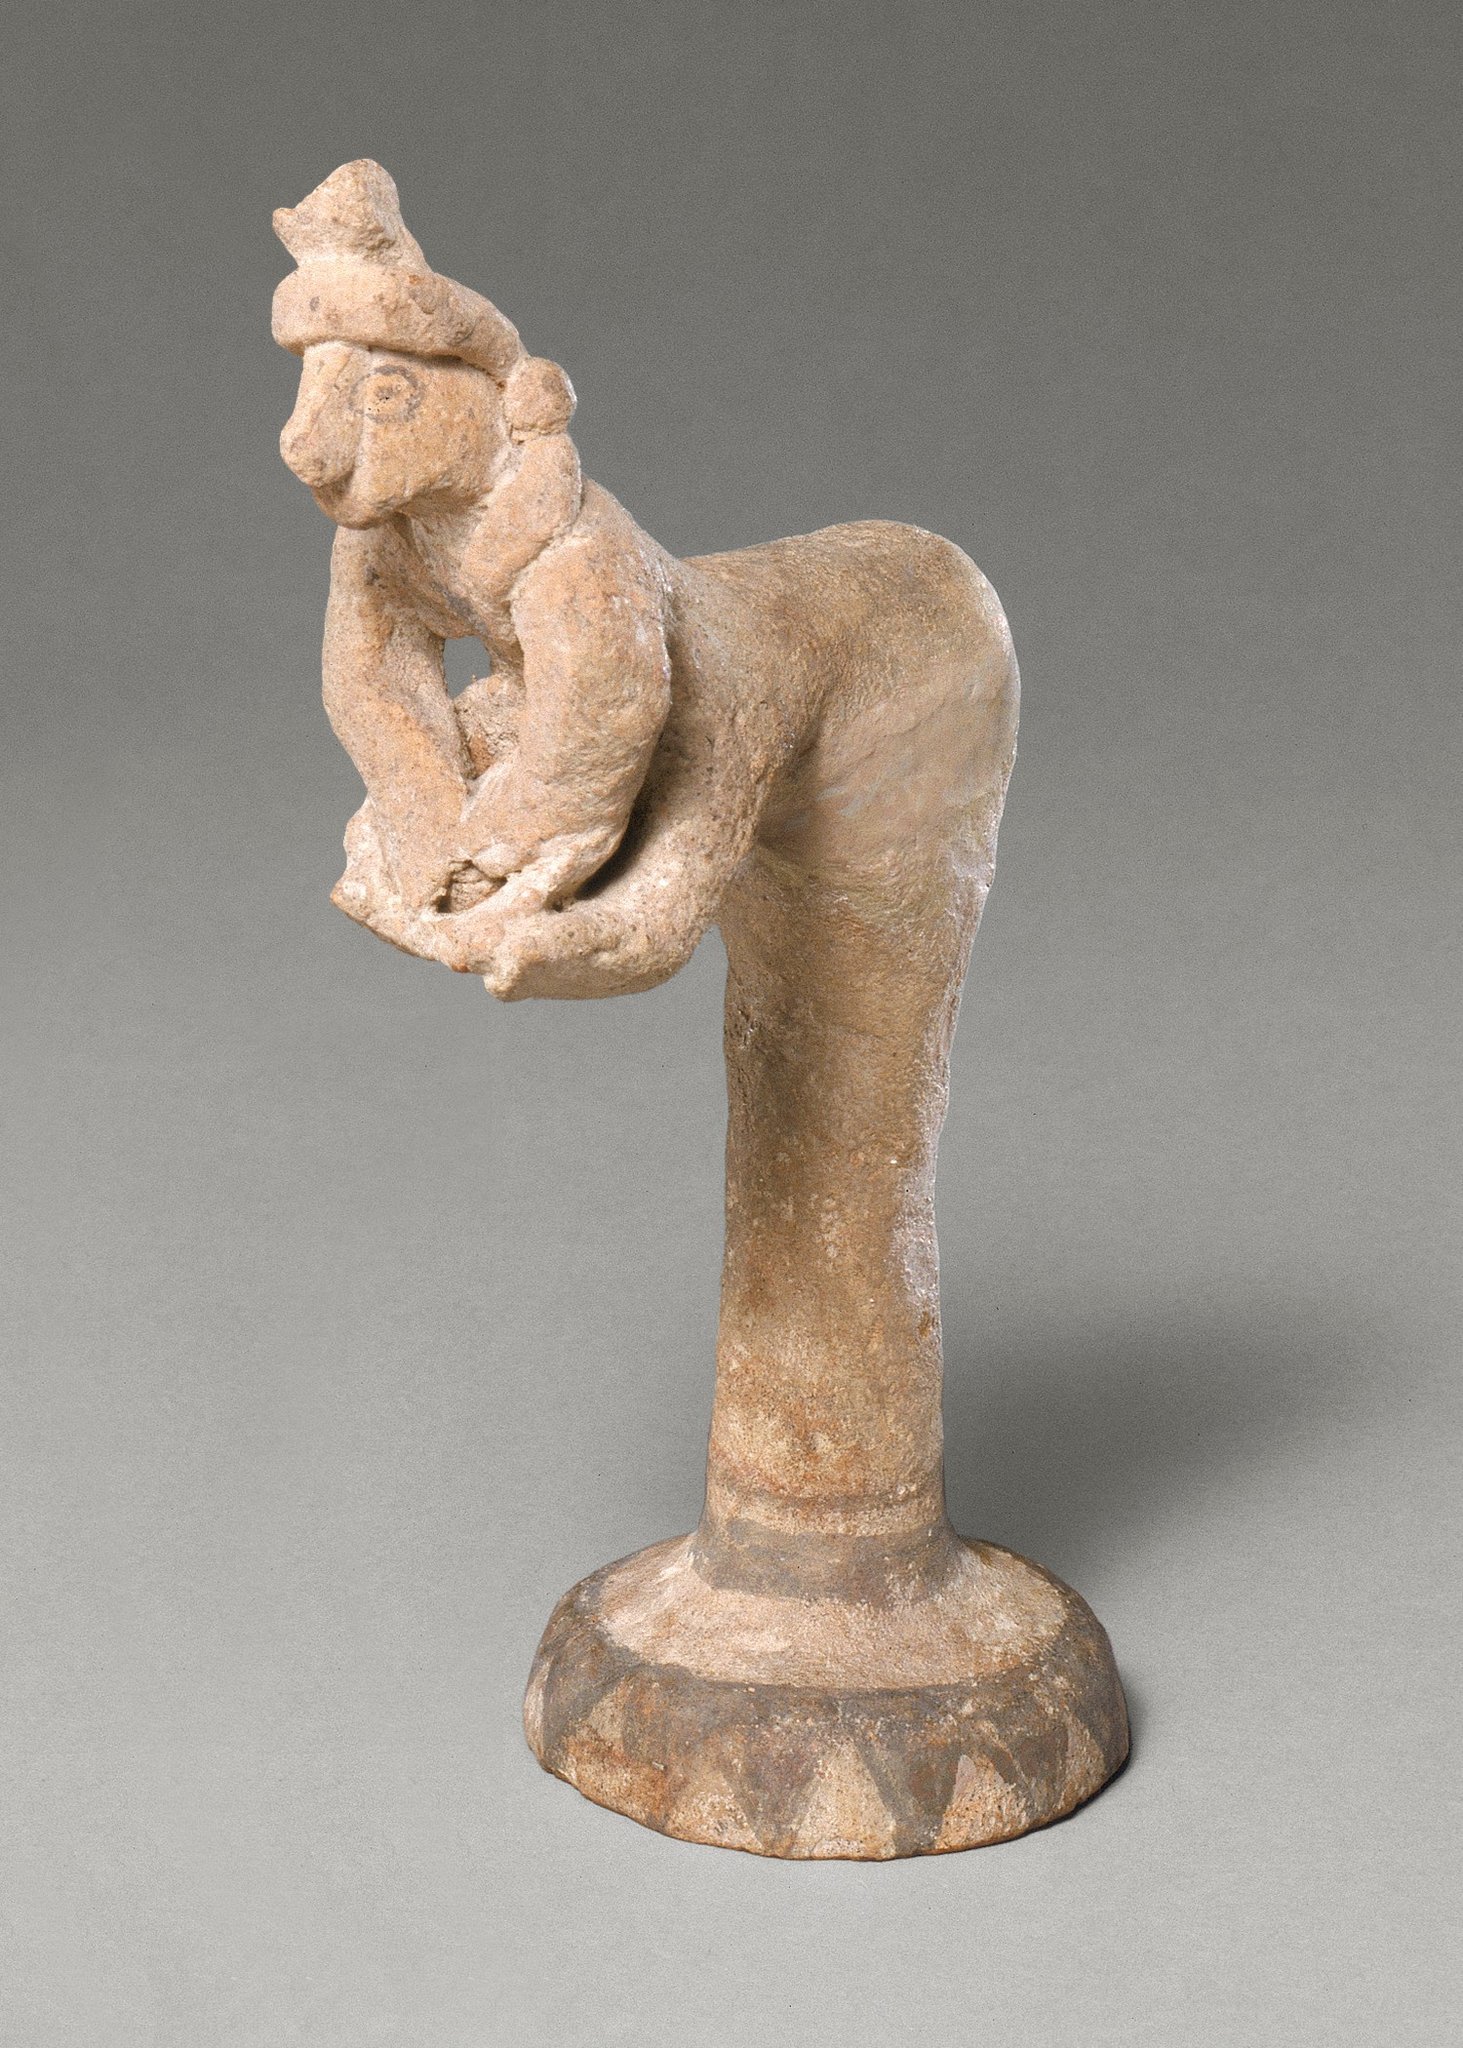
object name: statuette of a woman kneading dough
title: Female figurine kneading dough(?)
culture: cypriot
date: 600-480 BCE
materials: terracotta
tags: women